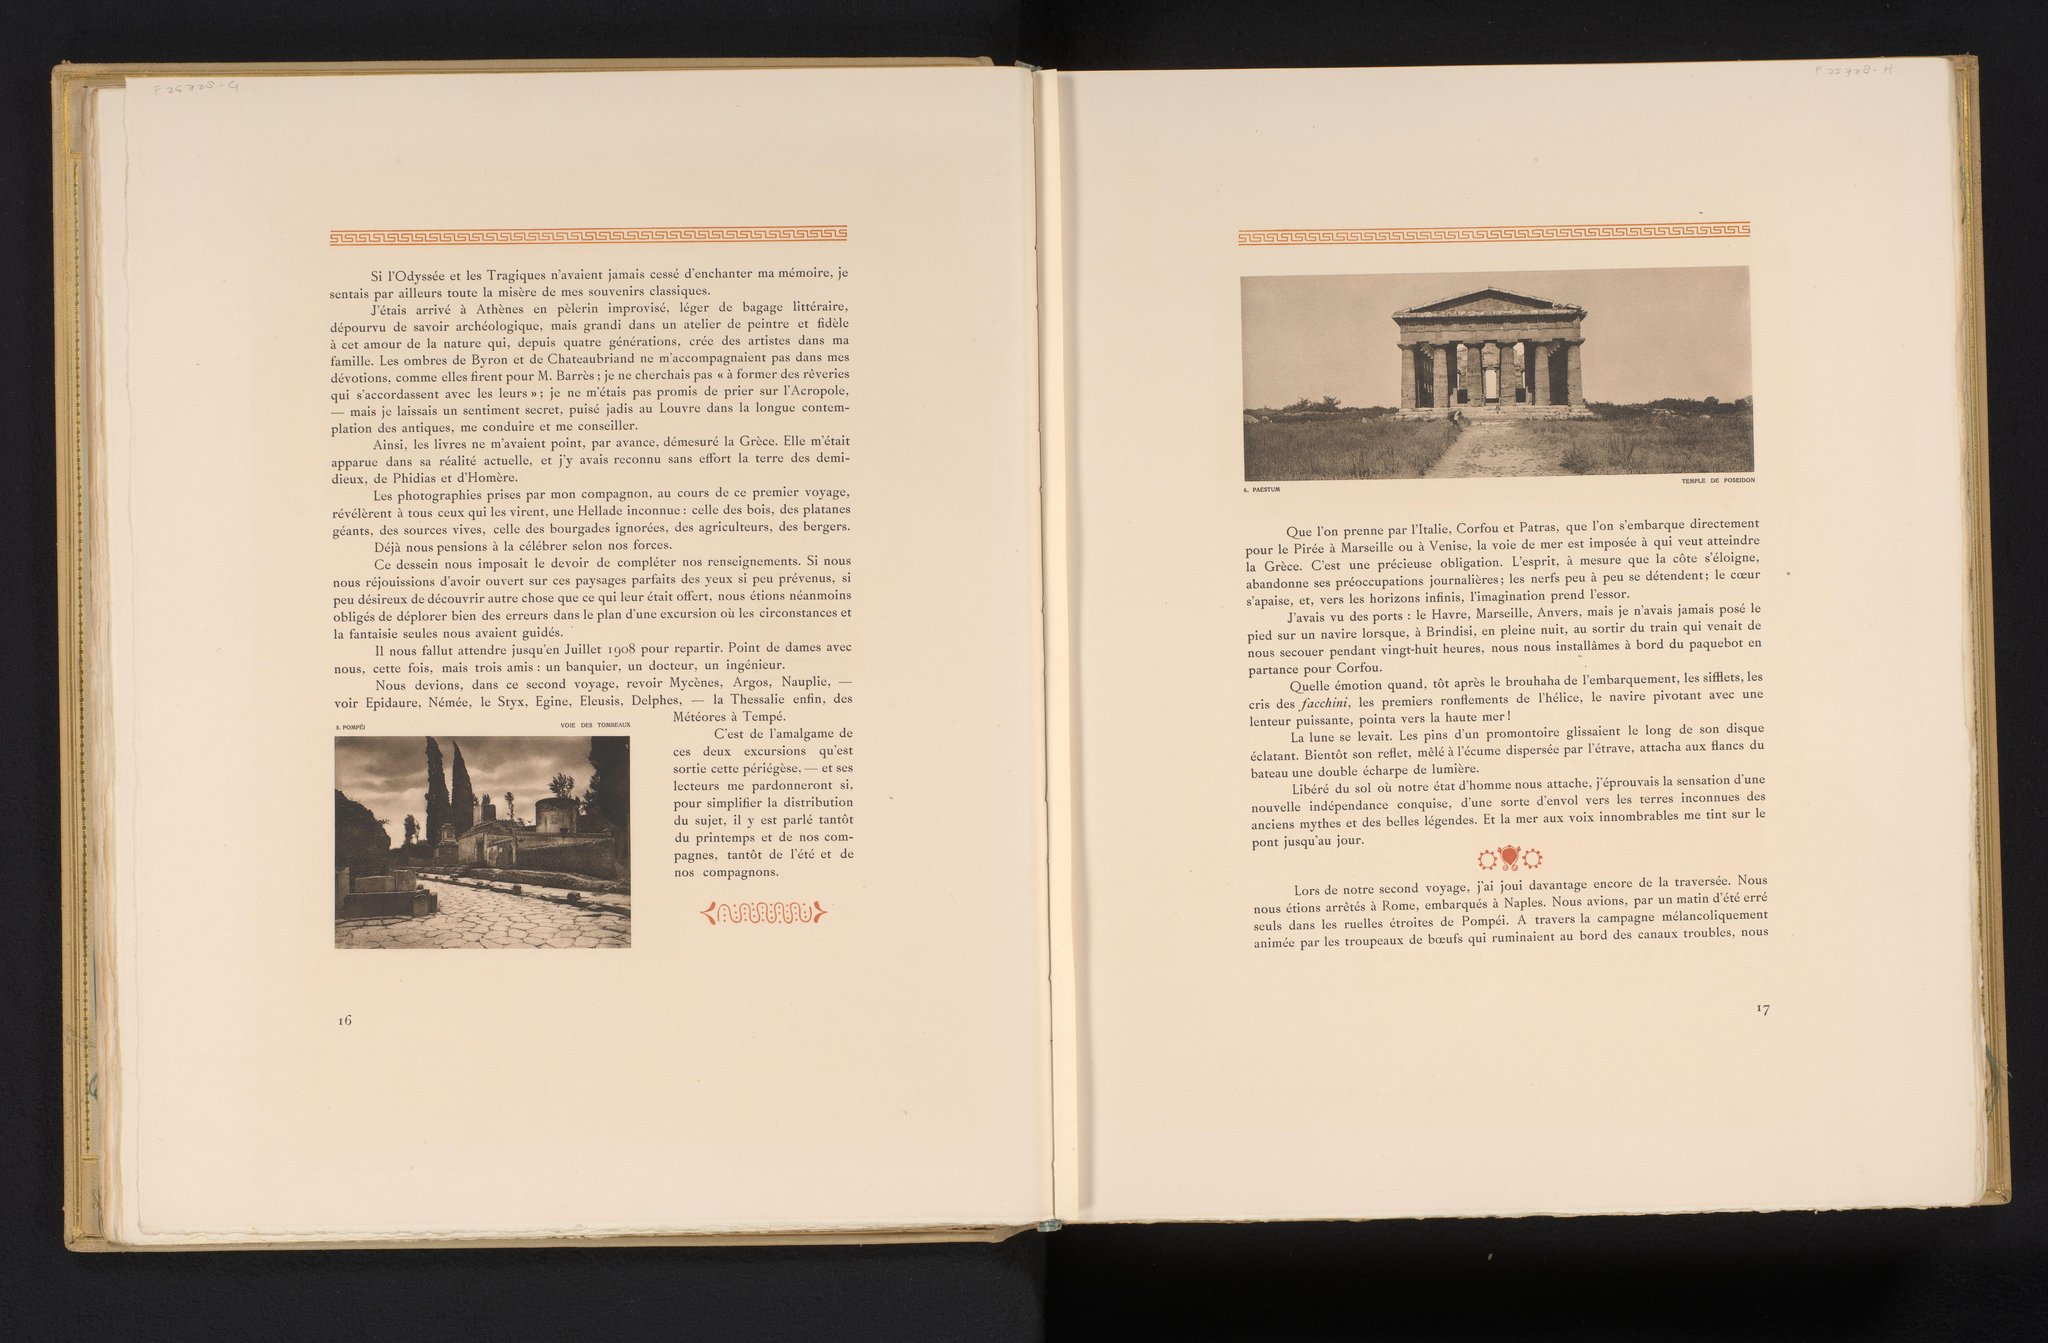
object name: page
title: Graftombes in Pompeï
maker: frédéric boissonnas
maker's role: fotograaf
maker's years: 1858-1946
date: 1905-1910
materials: paper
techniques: photograph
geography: berlin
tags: grave, tomb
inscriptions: number: ‘5.’